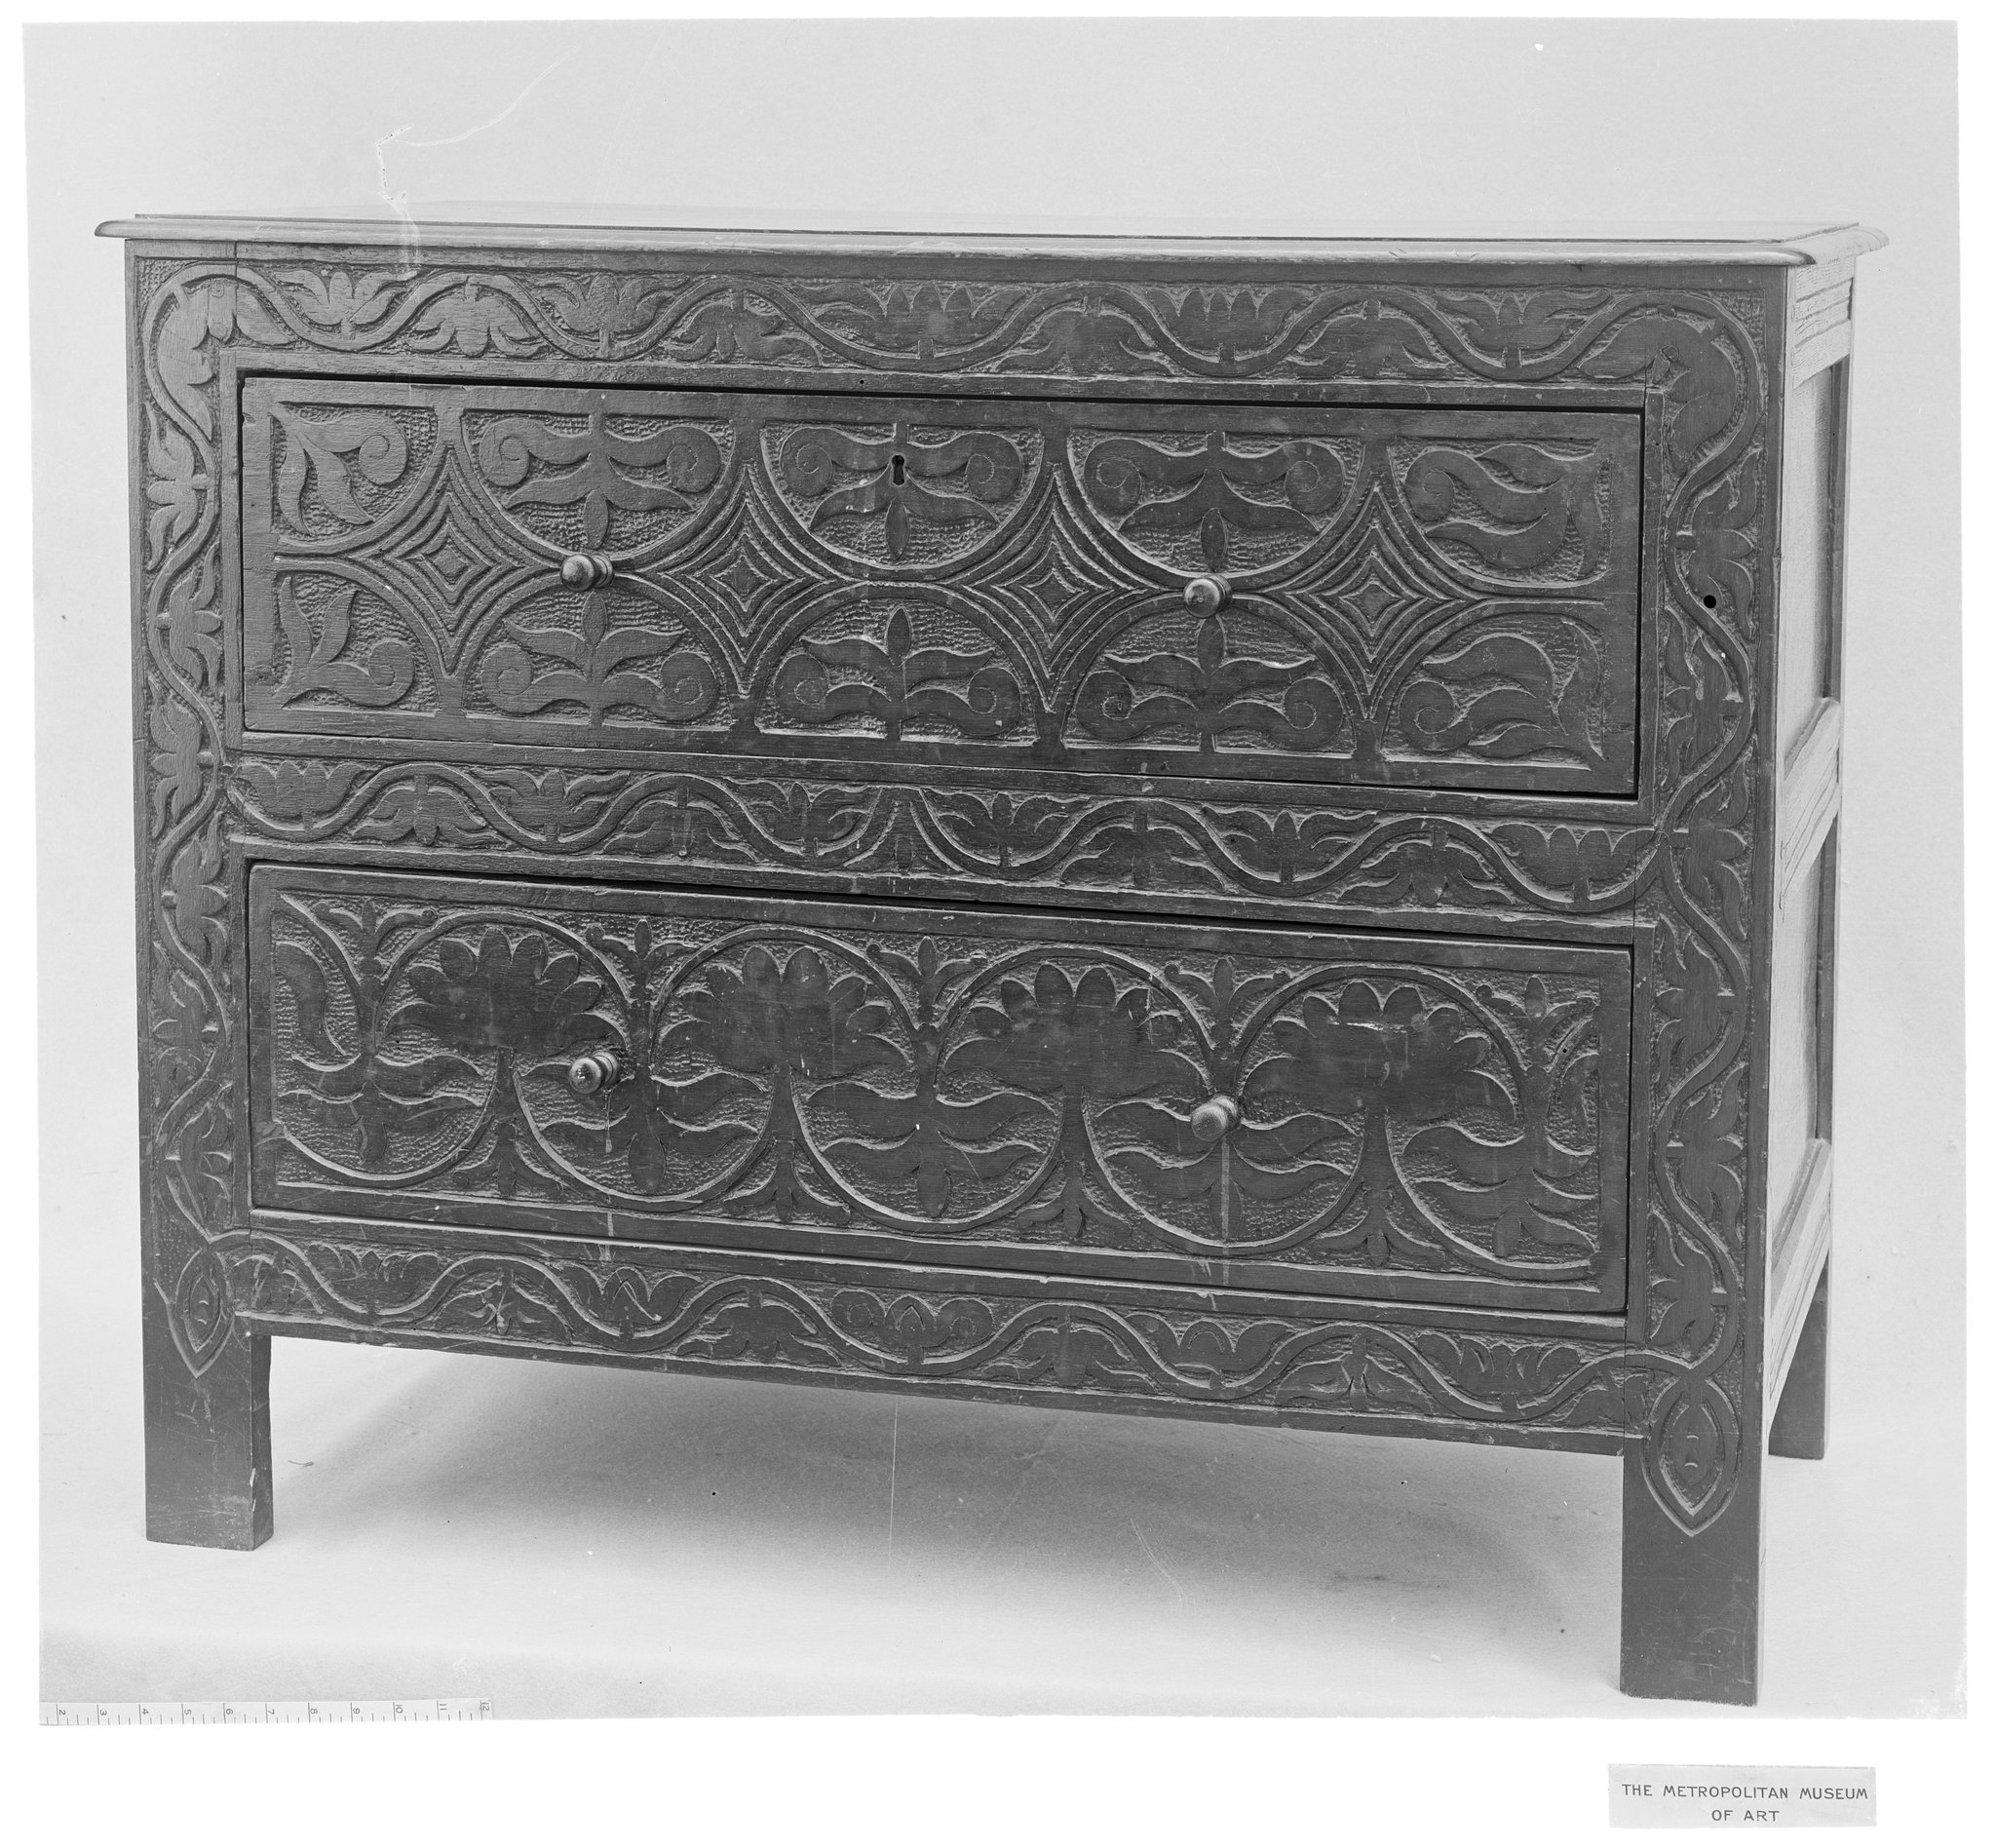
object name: chest of drawer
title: Chest of Drawers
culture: american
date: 1675-1700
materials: wood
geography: united states